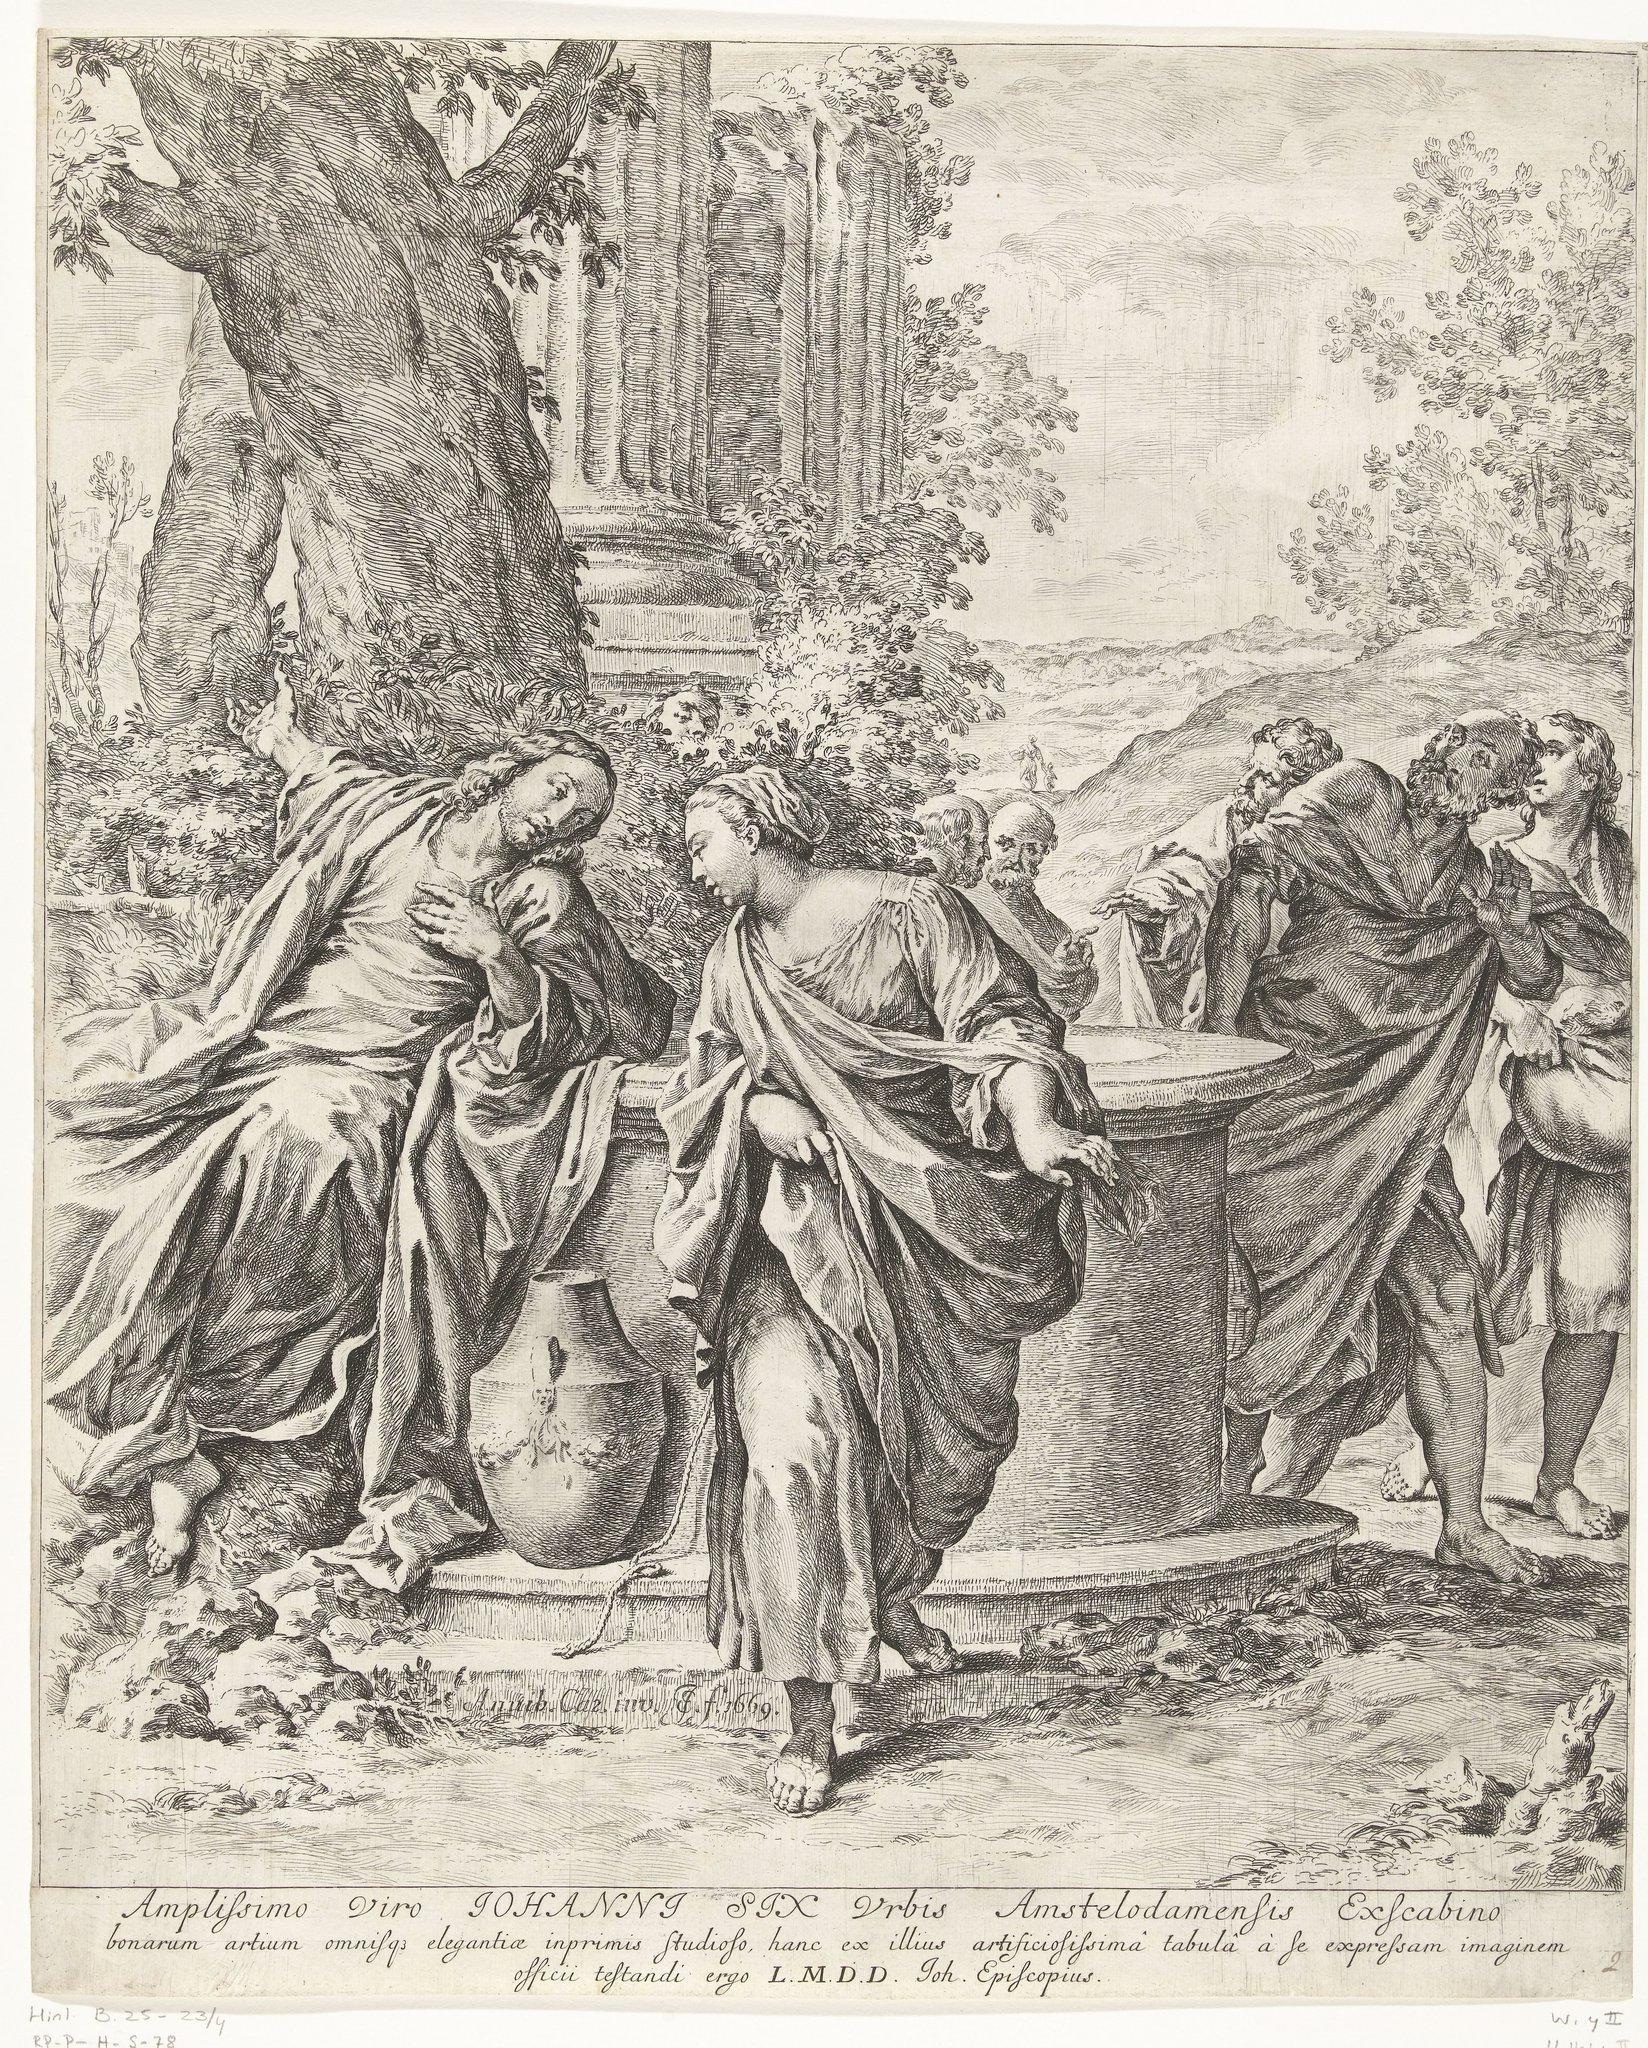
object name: print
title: Christus en de Samaritaanse vrouw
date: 1669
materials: paper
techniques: etching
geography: amsterdam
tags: well, christ and the woman of samaria: sitting at jacob's well he asks her for a drink from her jug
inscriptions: collector's mark: Lugt 11, collector's mark: Lugt 10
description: Christus zit bij een bron en vraagt aan een Samaritaanse vrouw of ze hem water kan geven. Op de achtergrond zijn zijn apostelen te zien.